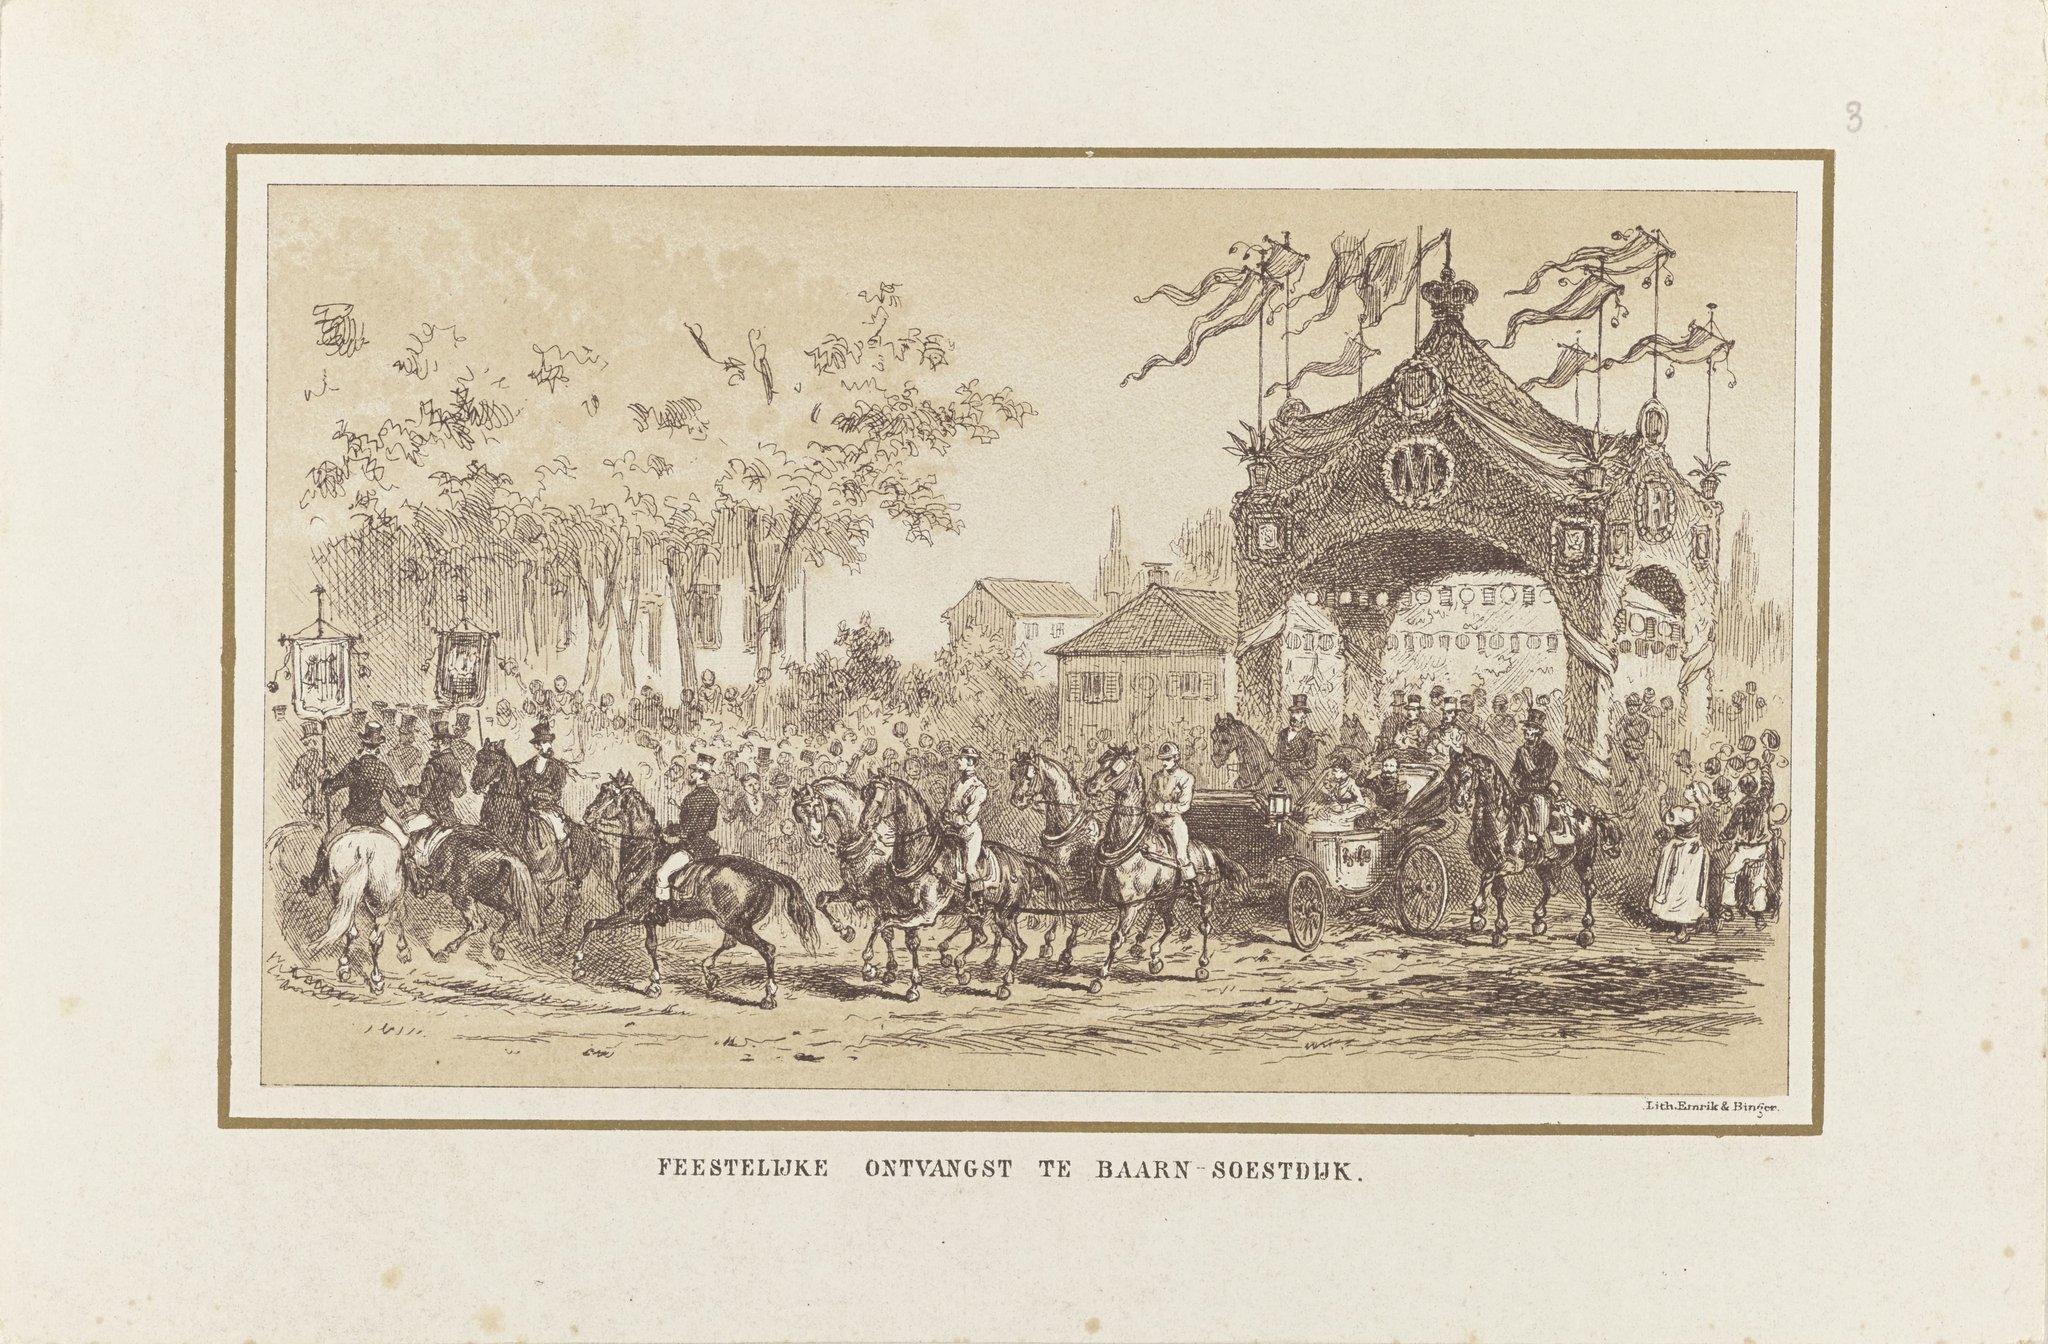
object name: print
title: Feestelijke ontvangst te Baarn-Soestdijk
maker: Anonymous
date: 1879-1880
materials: paper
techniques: tone lithography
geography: netherlands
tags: hendrik (prins der nederlanden), (civil) marriage ceremonies, public festivities at marriage of royal persons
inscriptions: collector's mark: Lugt 2228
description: Feestelijke ontvangst van het bruidspaar in Baarn en Soestdijk. Het paar rijdt in een open rijtuig door een versierde triomfpoort. Onderdeel van het souvenir bij het huwelijk op 24 augustus 1878 bestaande uit een reeks van acht prenten plus een begeleidend boekje.